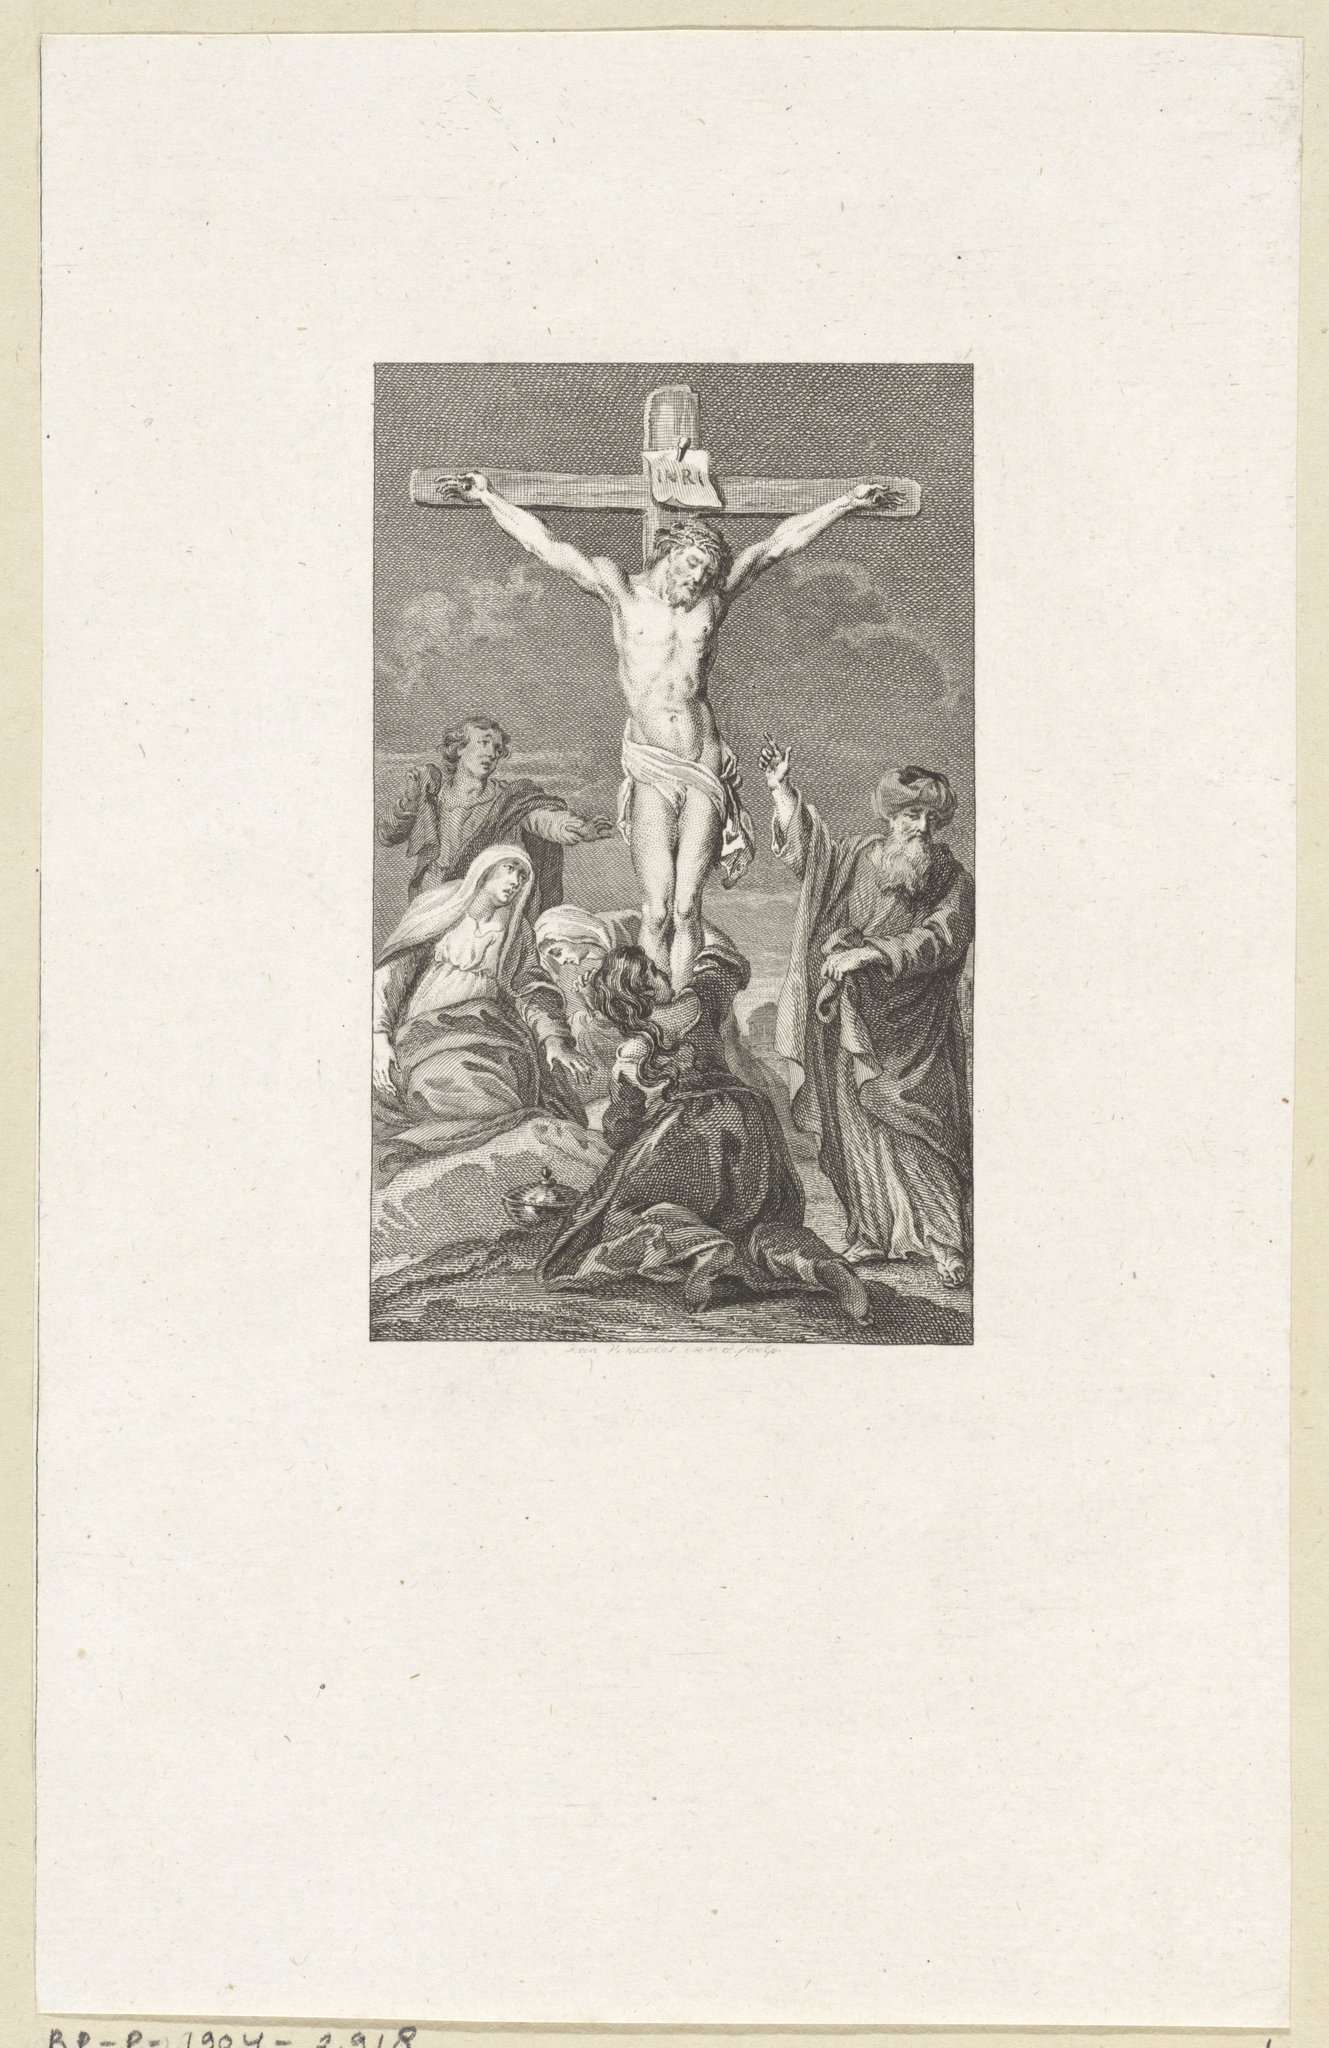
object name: print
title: Christus aan het kruis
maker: reinier vinkeles (i)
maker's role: draughtsman, print maker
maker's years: 1741-1816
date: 1785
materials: paper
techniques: engraving, etching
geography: amsterdam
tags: crucified christ with mary magdalene, who usually weeps and embraces the cross - dd - the three crosses, crucified christ with mary, john, and mary magdalene, night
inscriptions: collector's mark: Lugt 2228